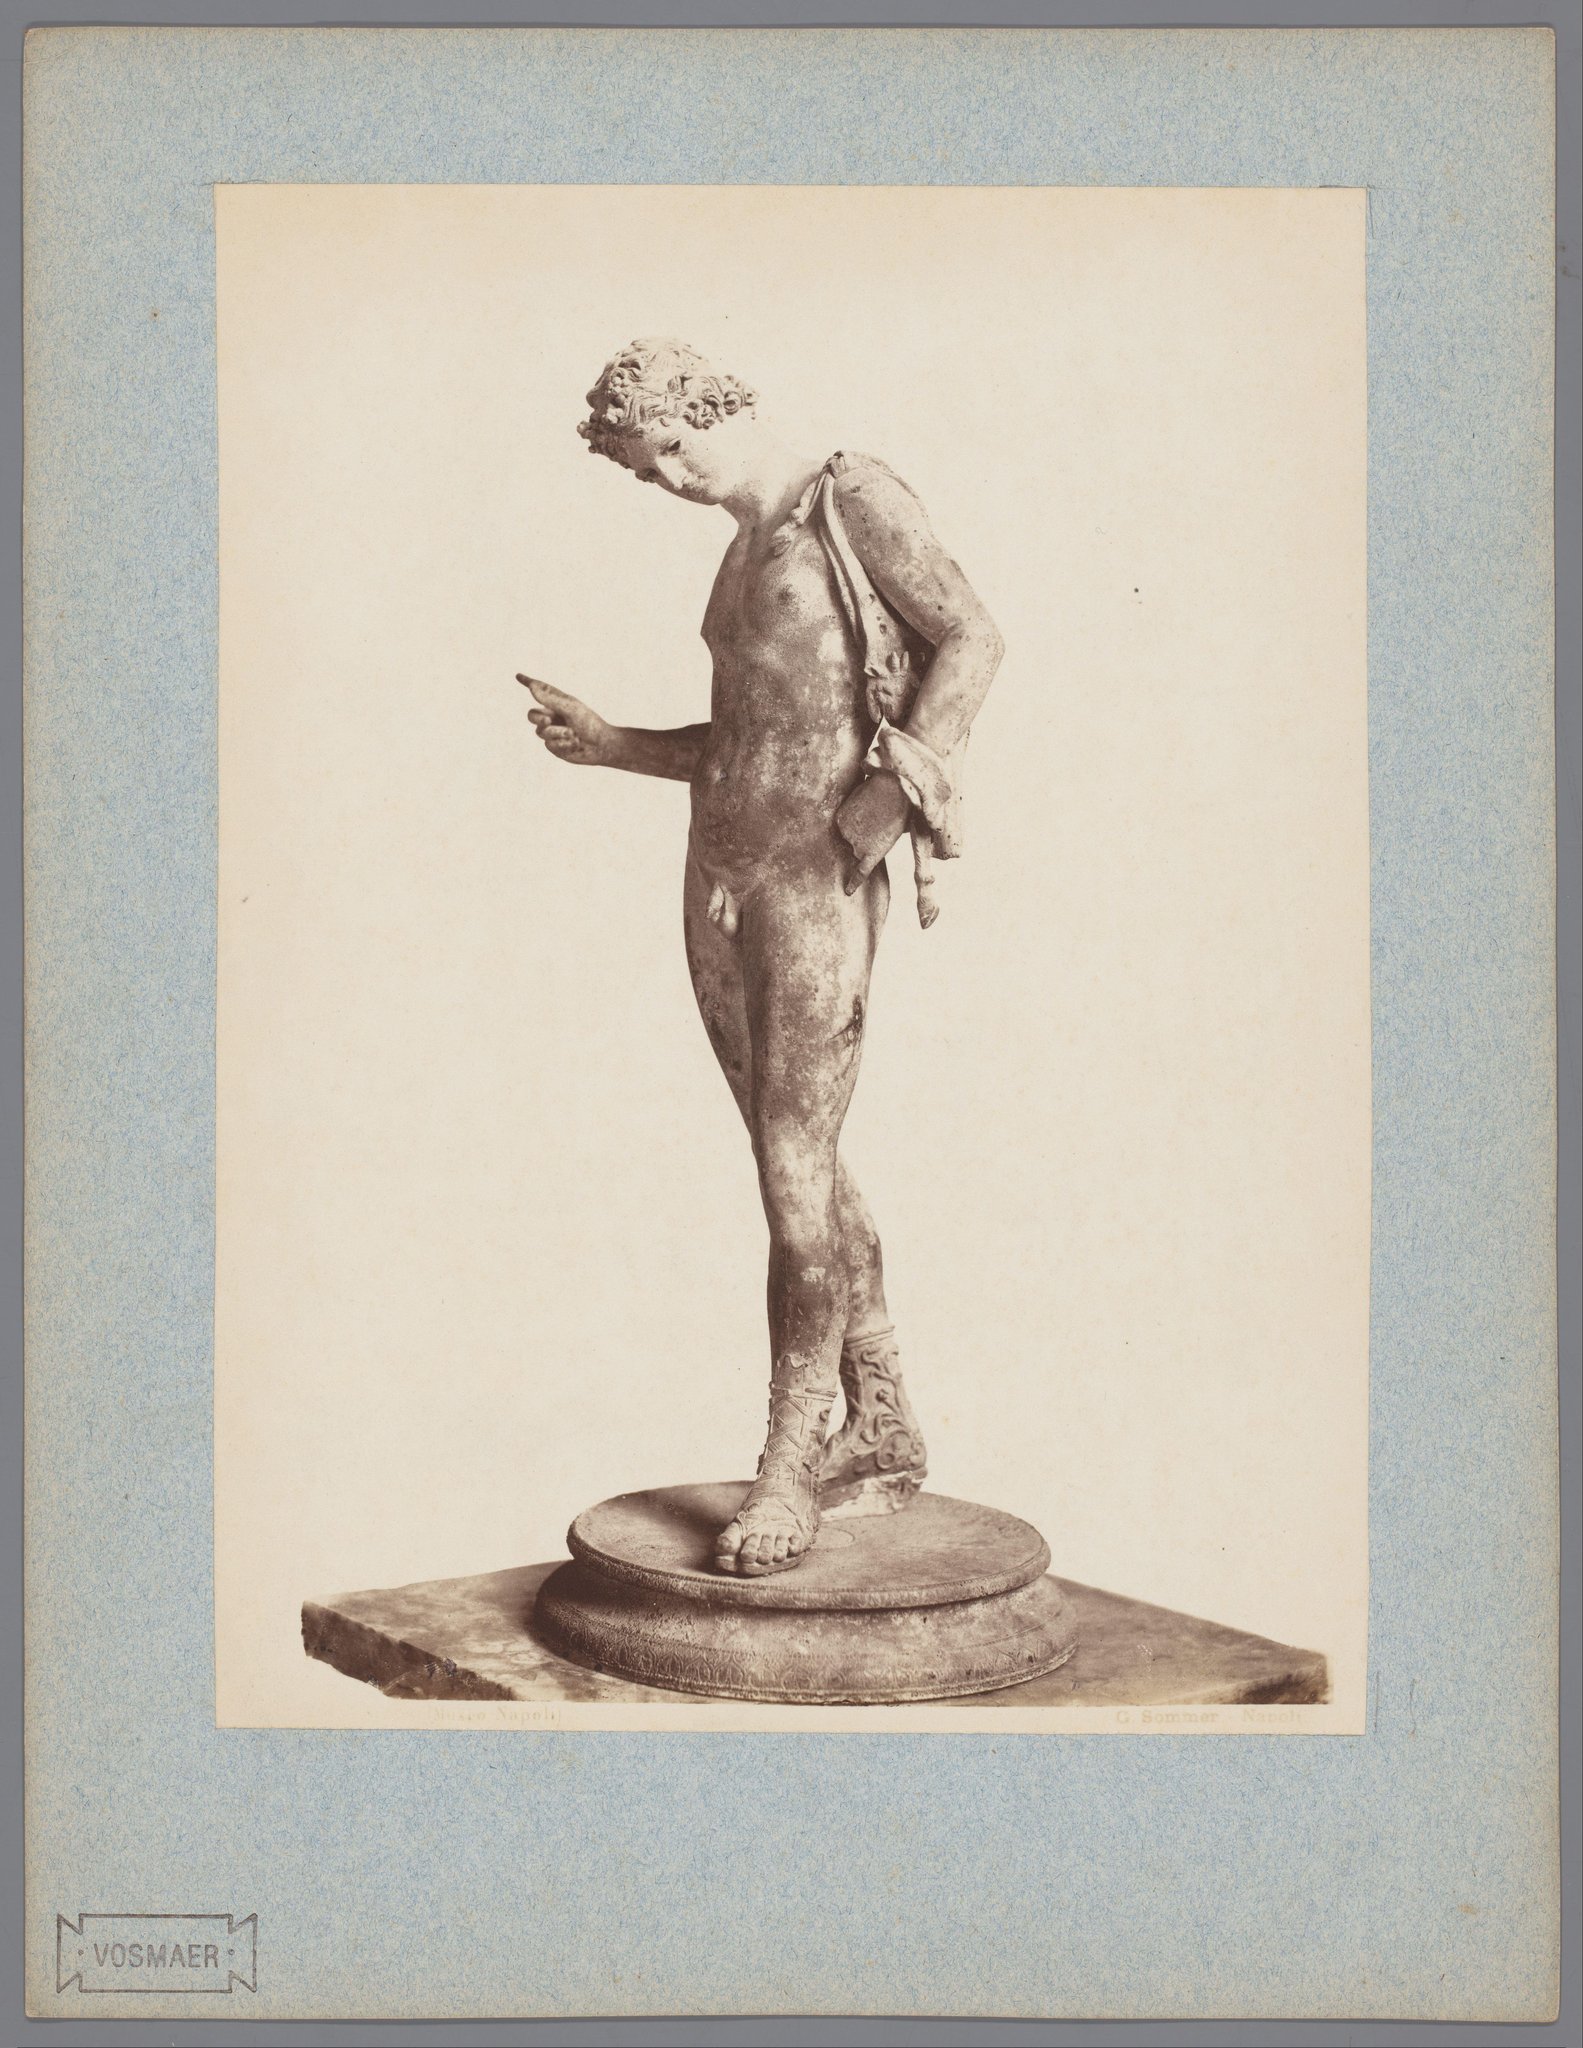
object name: photograph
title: Sculptuur van Narcissus in het Museo Archeologico Nazionale te Napels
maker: giorgio sommer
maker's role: fotograaf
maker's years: 1834-1914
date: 1857-1914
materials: cardboard, paper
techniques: albumen print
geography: naples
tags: (story of) narcissus, piece of sculpture, reproduction of a piece of sculpture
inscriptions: collector's mark: ‘VOSMAER’